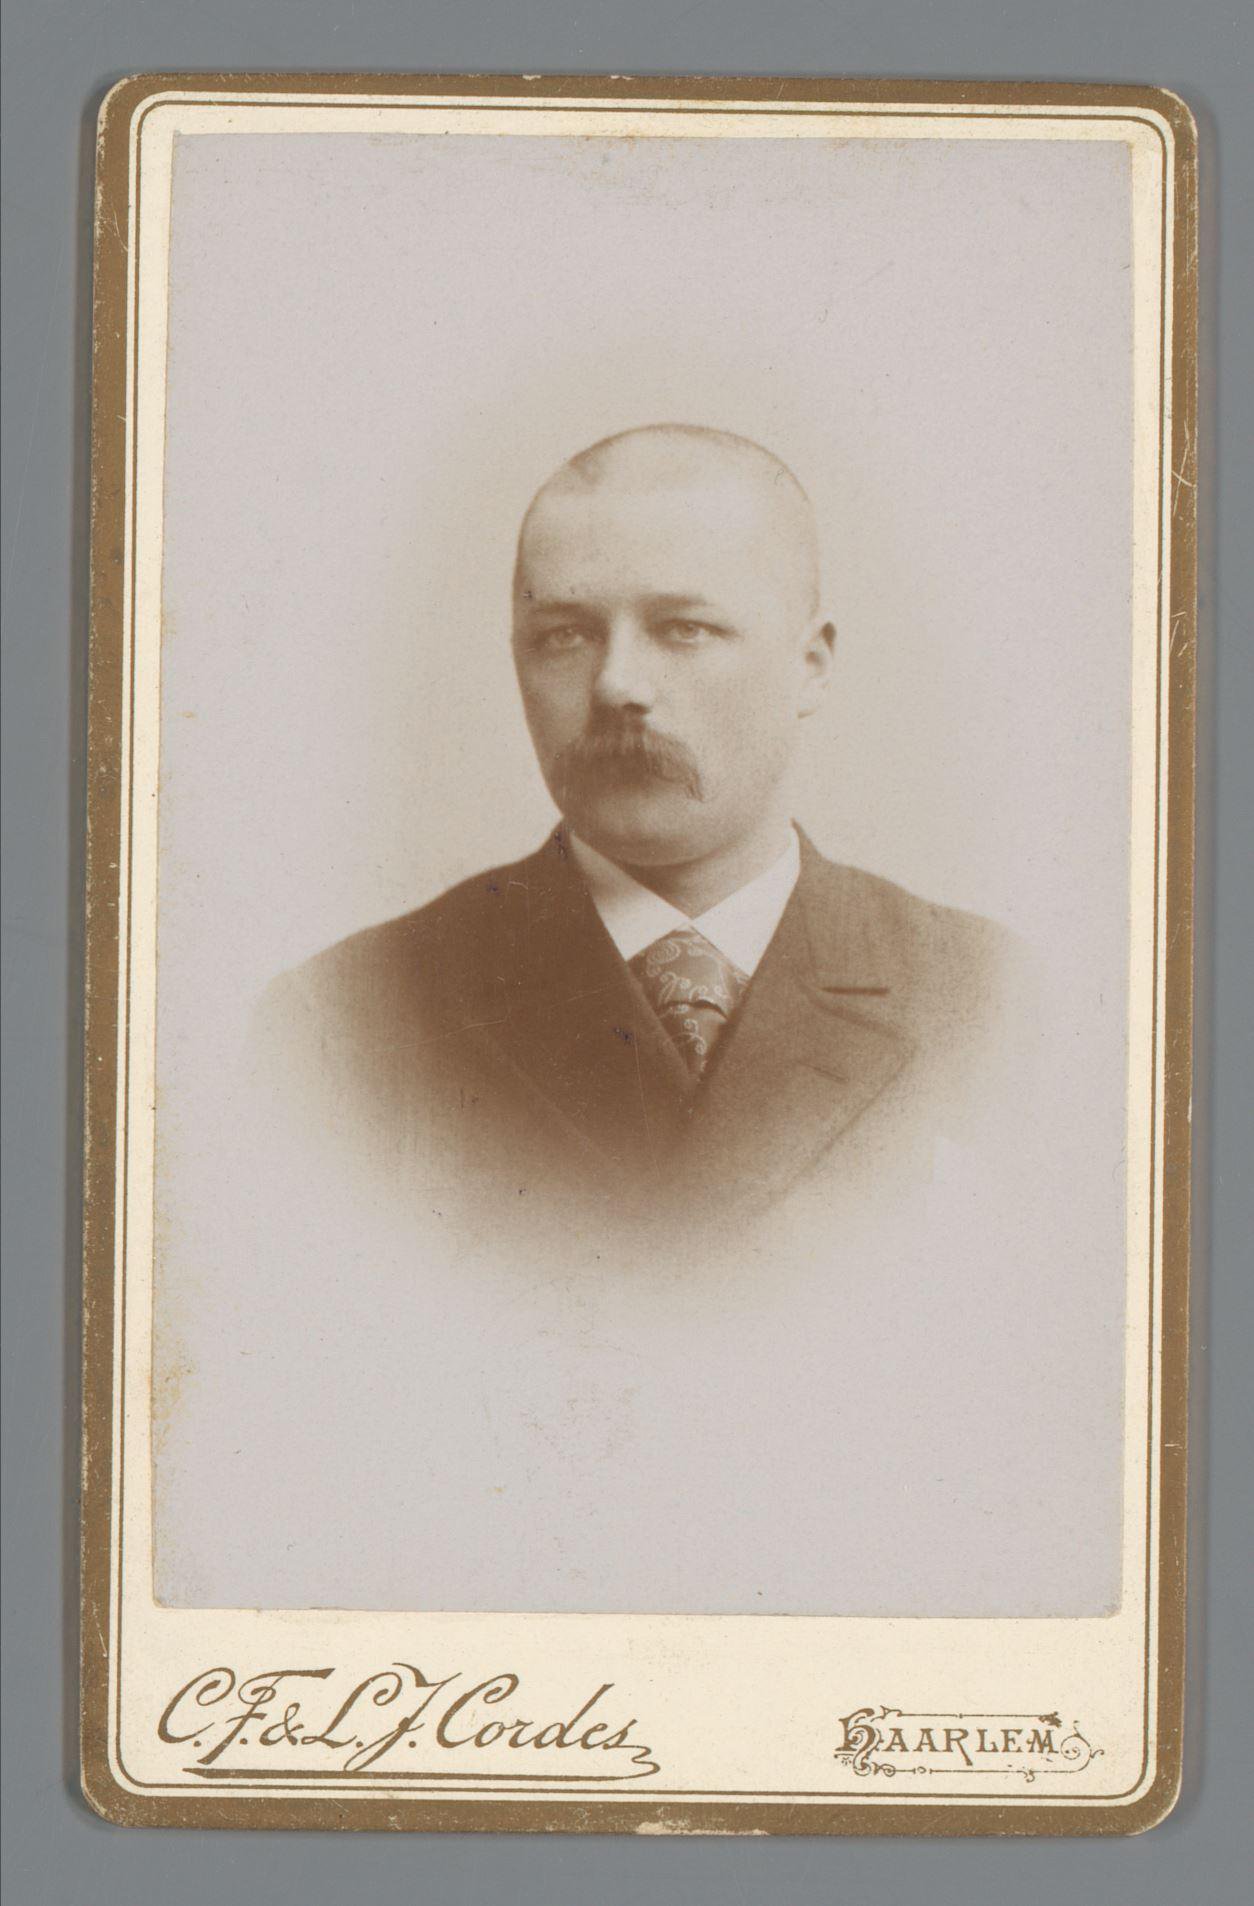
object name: carte de visite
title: Portret van Lucas Jonker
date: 1870-1920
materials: cardboard, photographic support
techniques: gelatin silver print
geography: haarlem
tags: historical persons, haarlem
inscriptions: workshop stamp: ‘C.F. & LJ. Cordes/ Haarlem, Groote Houtstraat 84/ 's Bosch a/d. Parade’, inscription: ‘Lucas Jonker lzn’